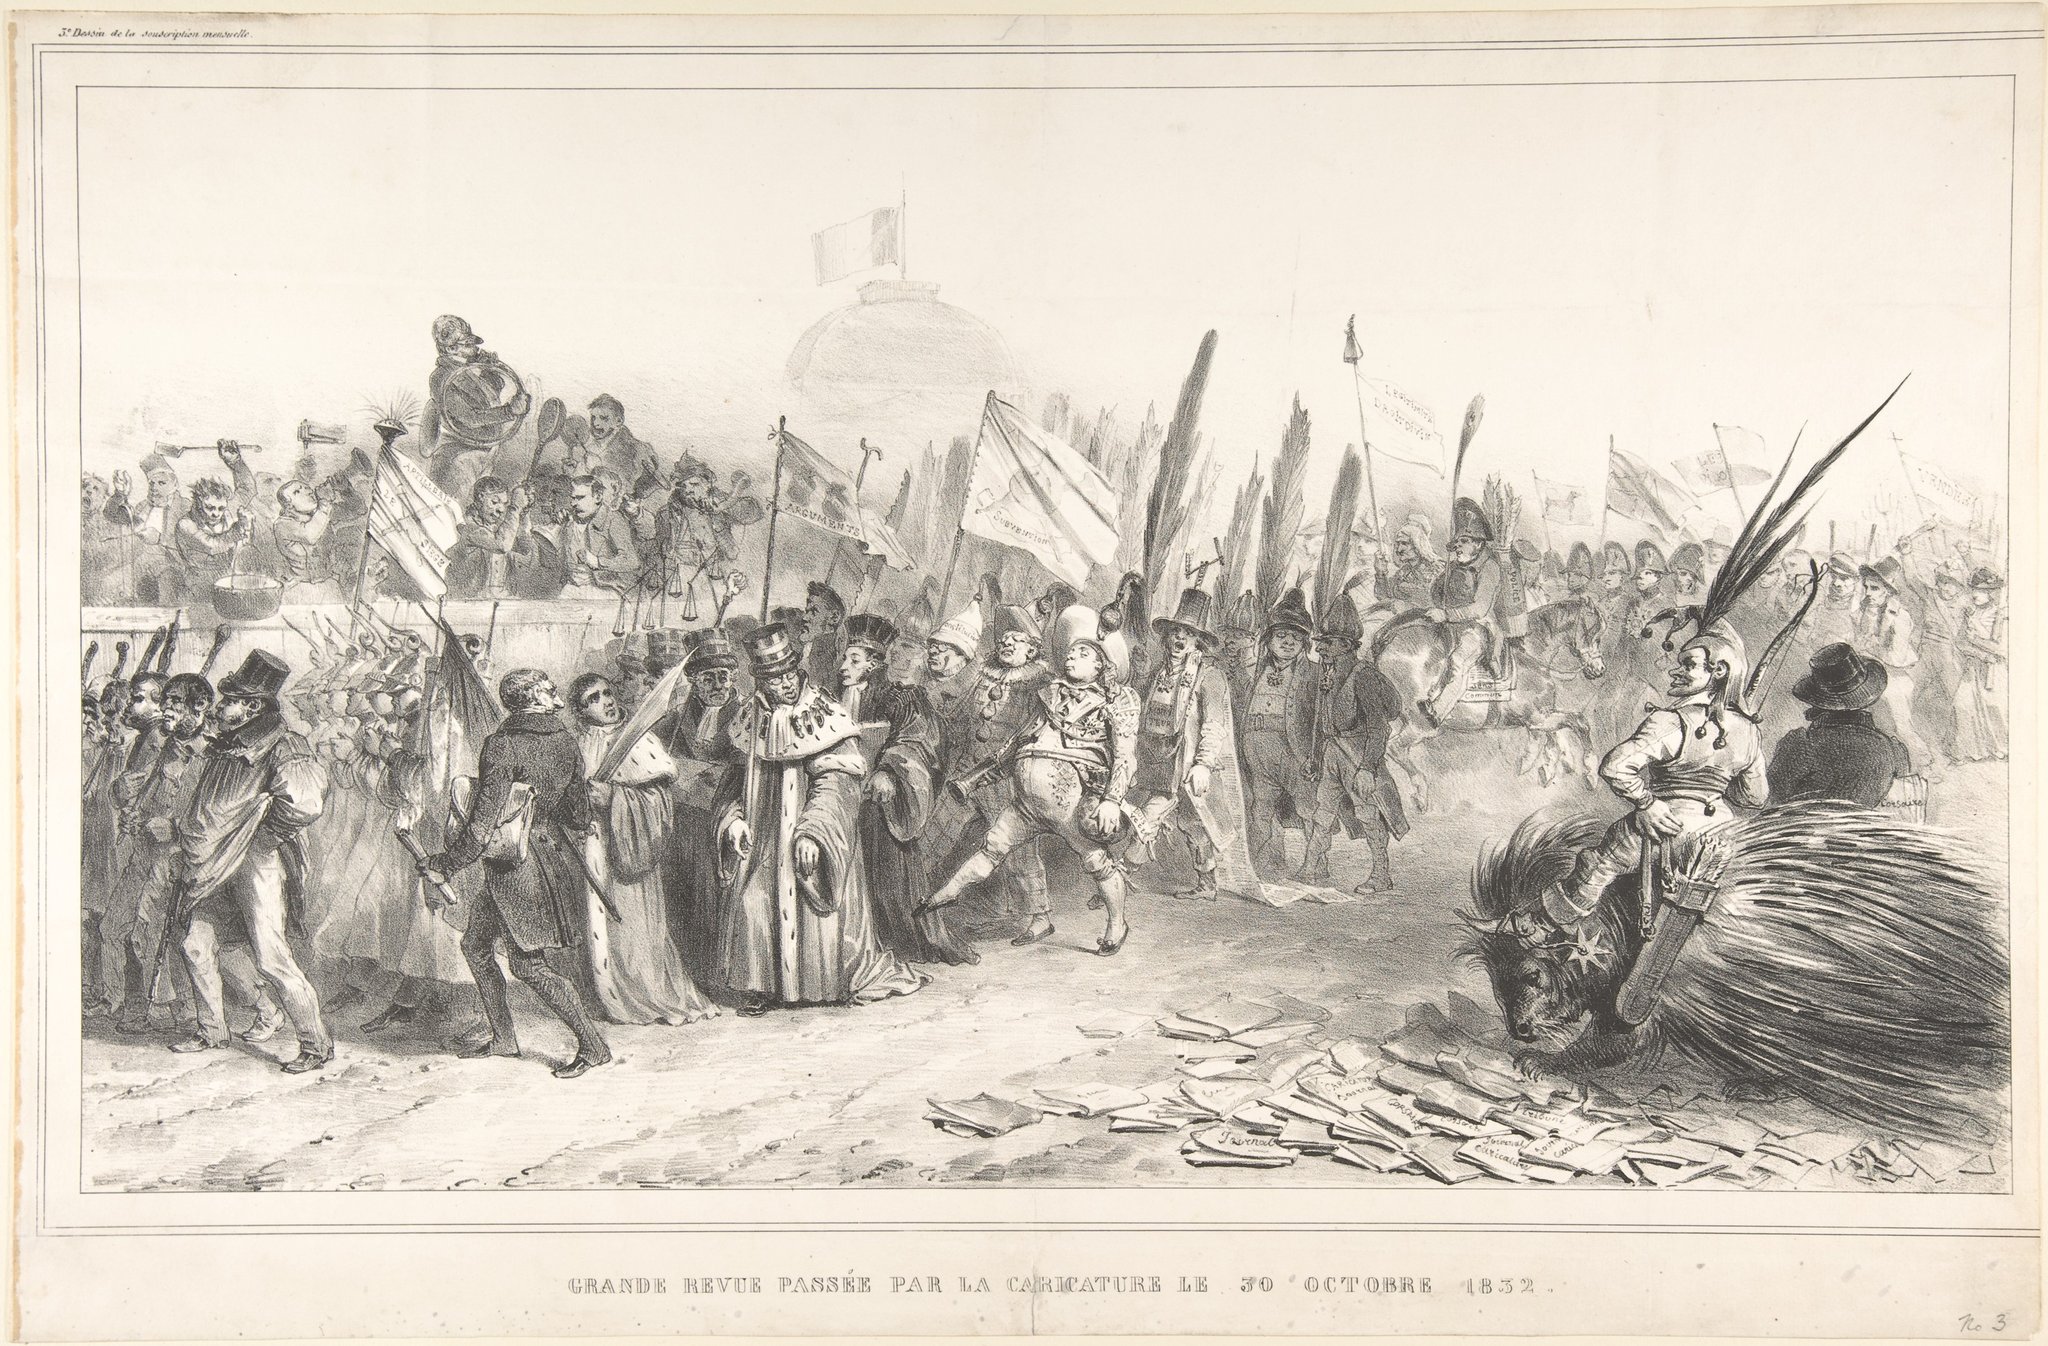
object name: print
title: The Grand Review of the Juste-Milieu Passing La Caricature, October 30, 1832 (Grand revue passée par la caricature le 30 Octobre 1832), from "L'Association Mensuelle no. 3"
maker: j. j. grandville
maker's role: artist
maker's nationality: french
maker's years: 1803-1847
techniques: lithograph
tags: animals,weapons,men,crowd,flags